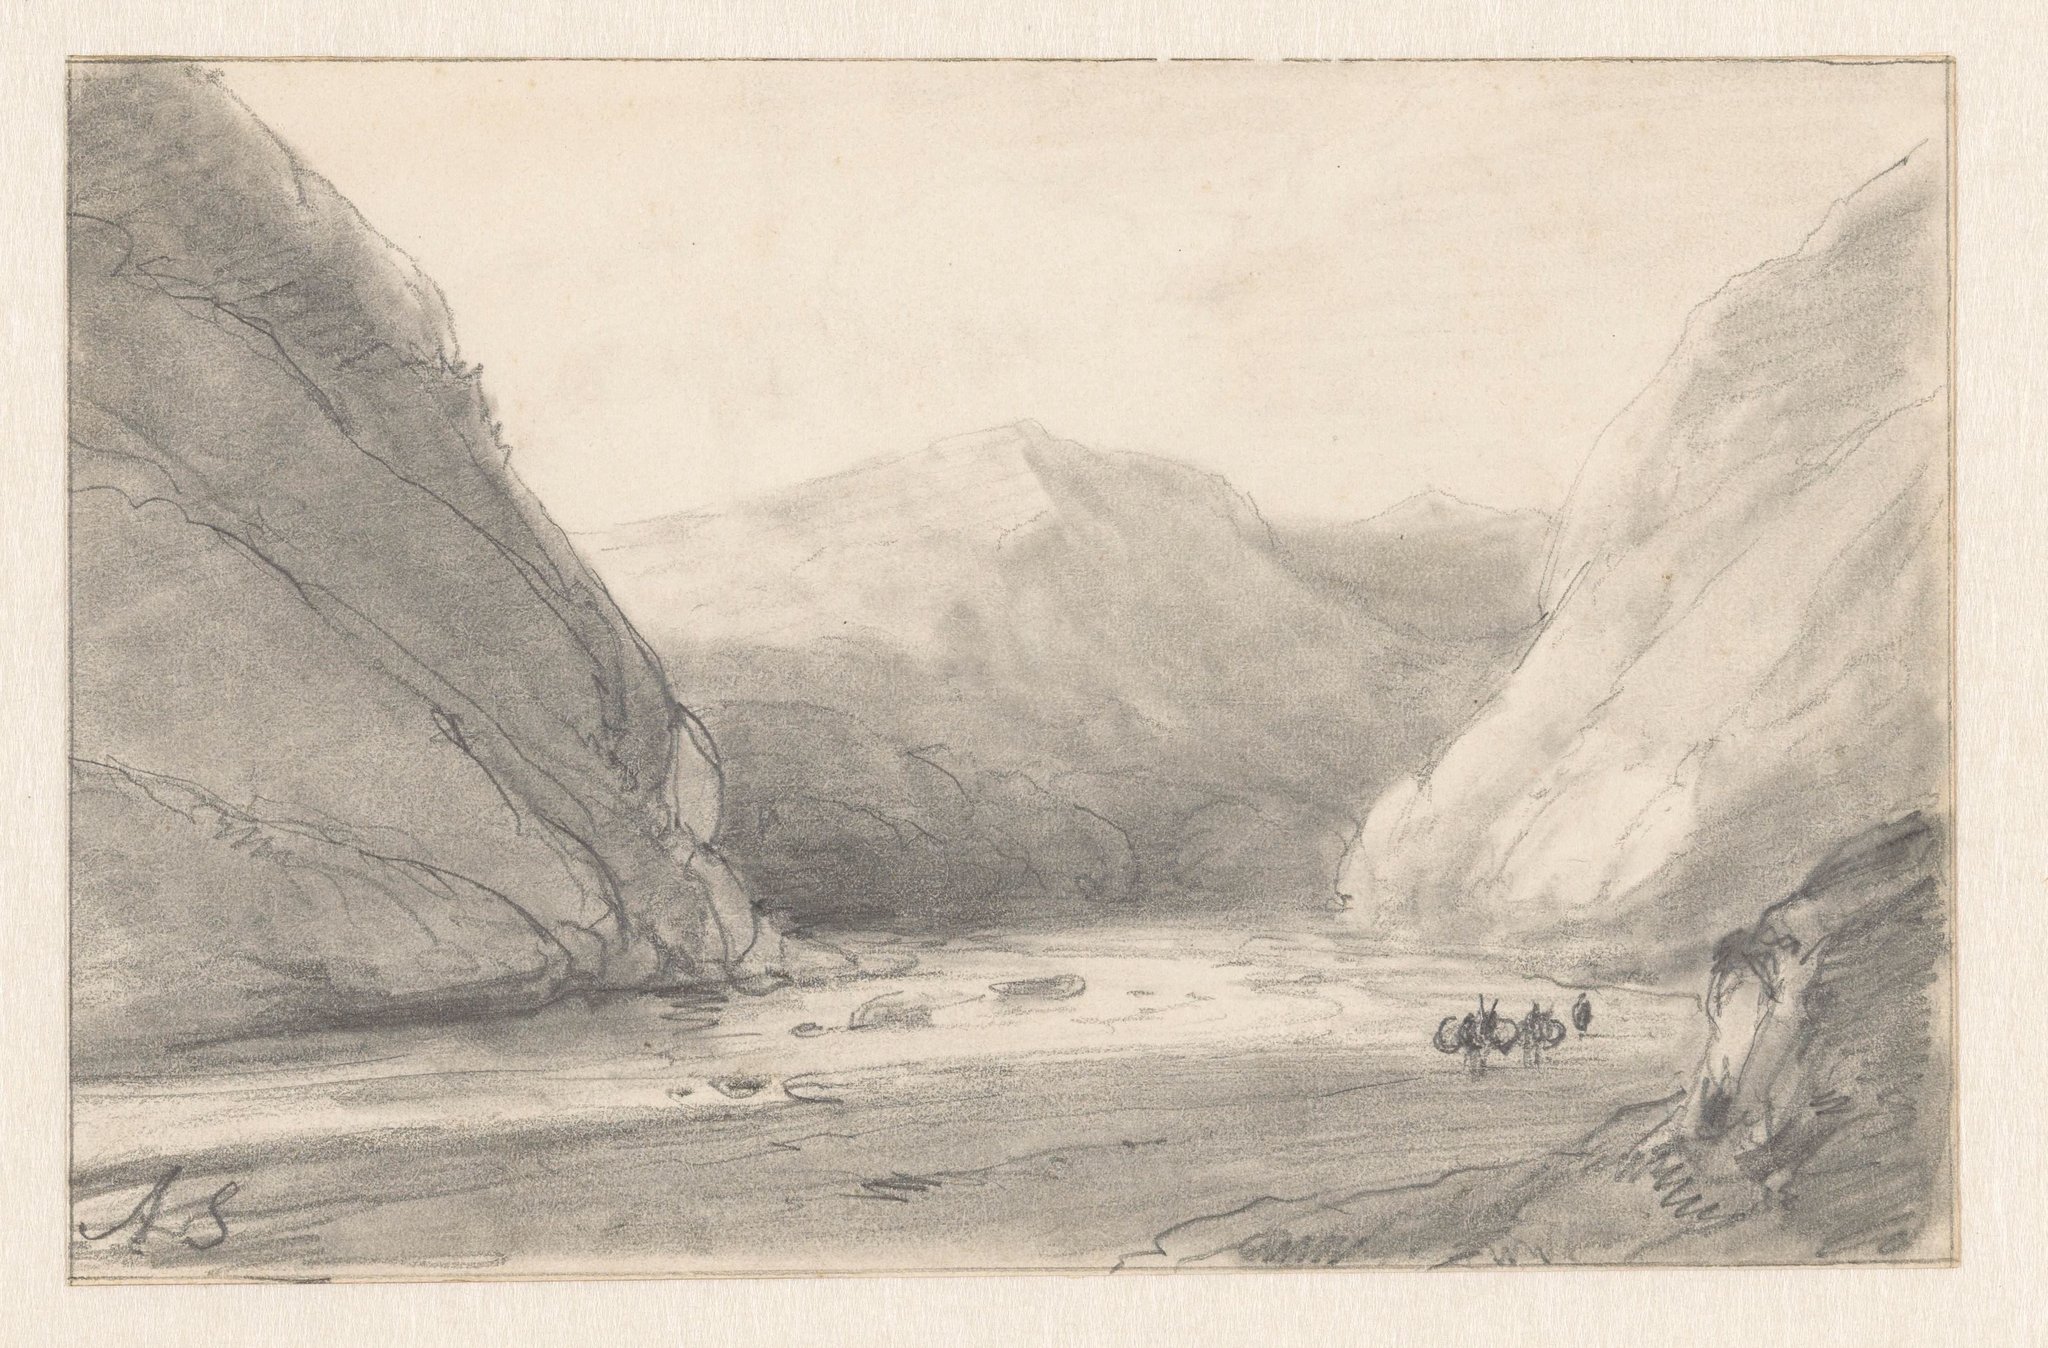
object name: drawing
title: Berglandschap met rivier en een figuur met twee bepakte ezels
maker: andreas schelfhout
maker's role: draughtsman, painter, print maker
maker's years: 1787-1870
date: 1797-1870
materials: paper, pencil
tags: mountains